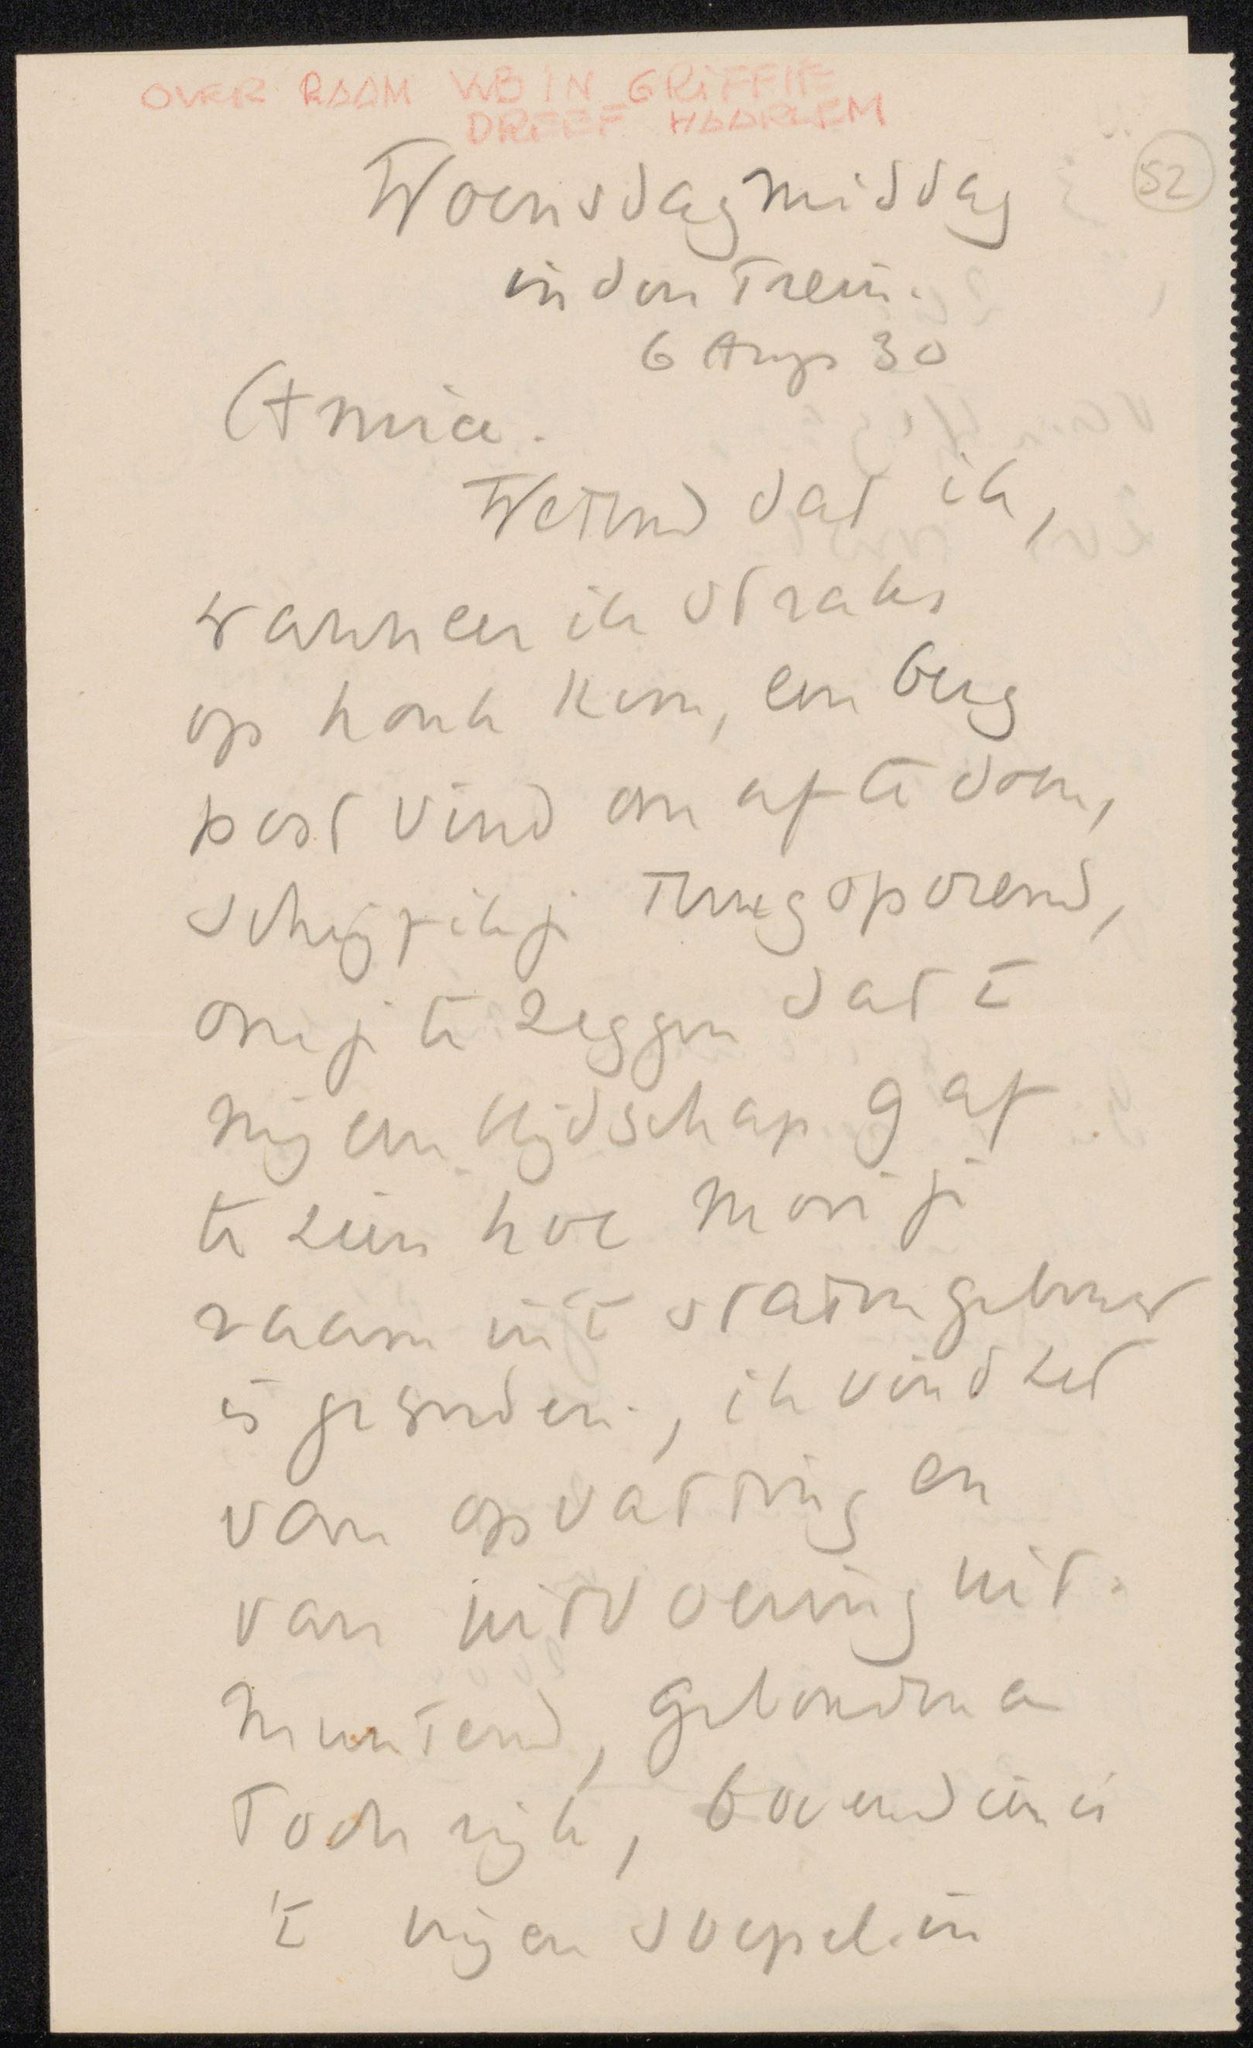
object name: letter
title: Brief aan Willem Bogtman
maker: richard nicolaüs roland holst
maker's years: 1868-1938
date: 1930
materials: paper, pencil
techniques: writing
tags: haarlem, willem bogtman, applied arts, arts and crafts; industrial design, paris, amsterdam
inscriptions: watermark